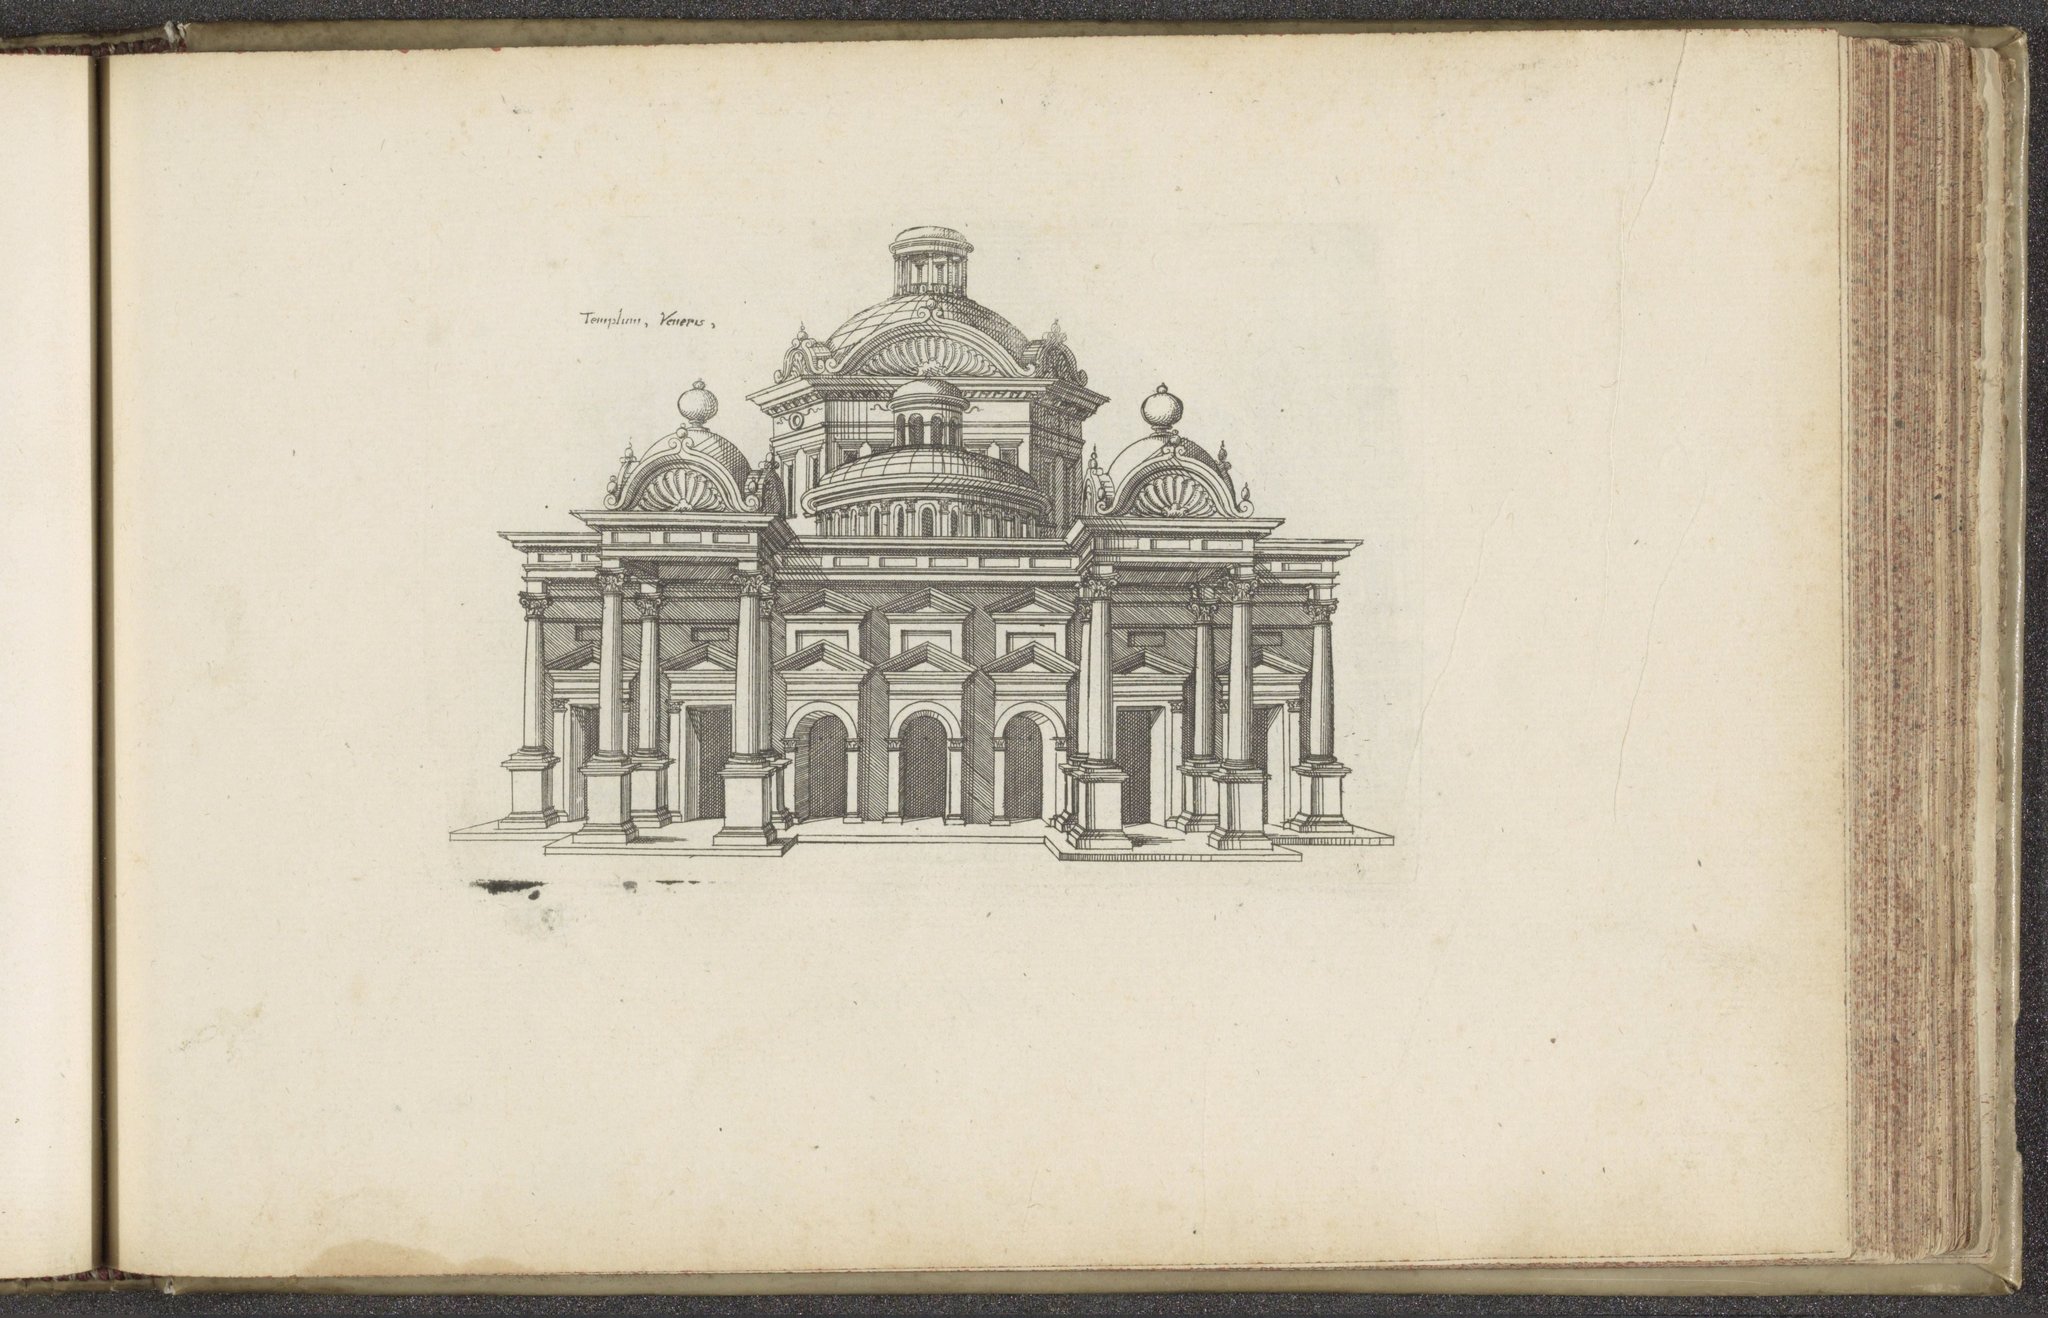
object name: print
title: Tempels en kerken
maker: jacques androuet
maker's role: draughtsman, print maker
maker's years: 1515-1584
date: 1550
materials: paper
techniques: etching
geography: orléans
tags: temple, shrine ~ roman religion, exterior ~ representation of a building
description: Tempel van Venus met een centrale koepel en timpanen met schelpornament. Deze prent maakt deel uit van een album.